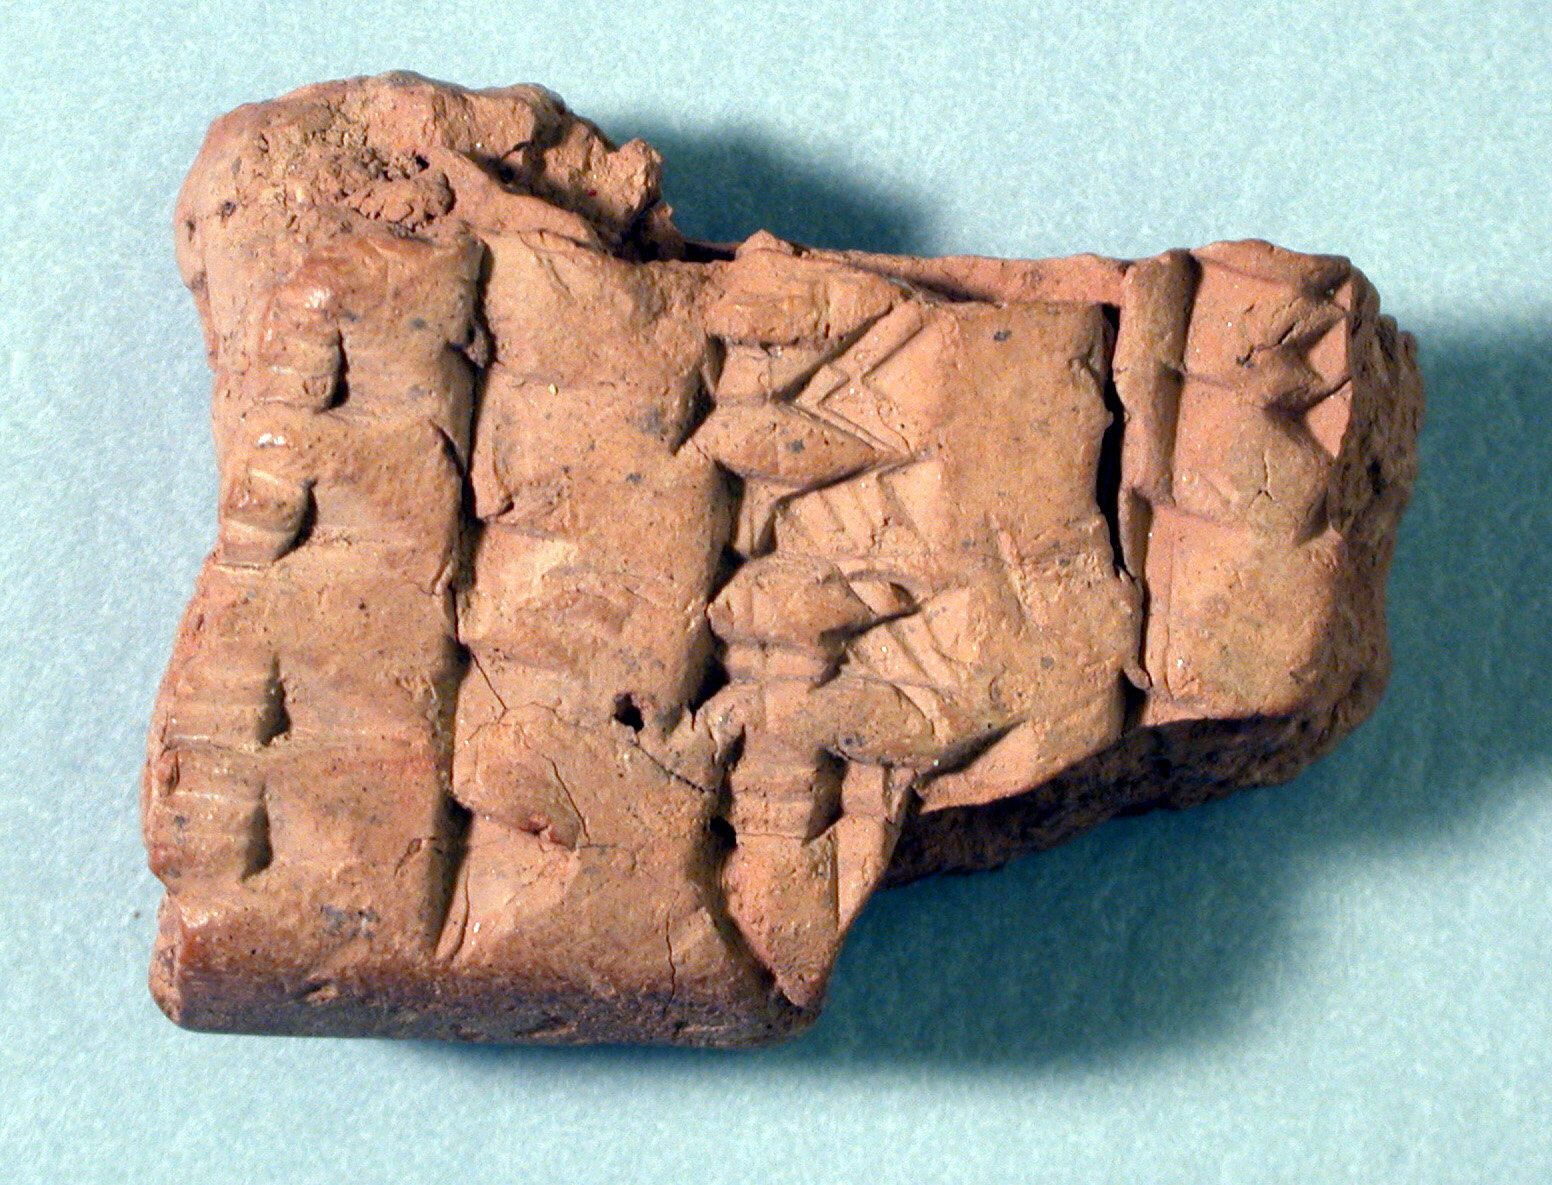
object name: cuneiform tablet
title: Cuneiform tablet: fragment of Syllabary A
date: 333-1 BCE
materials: clay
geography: mesopotamia